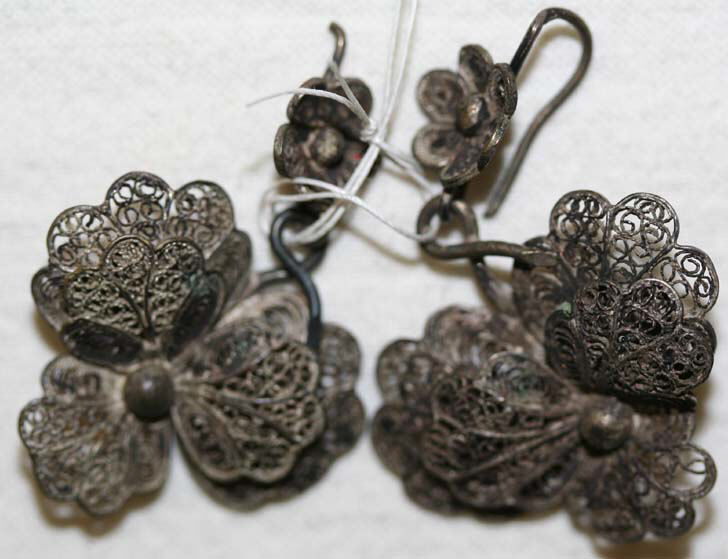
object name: earring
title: Earrings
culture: european, eastern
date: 1701-1900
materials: metal